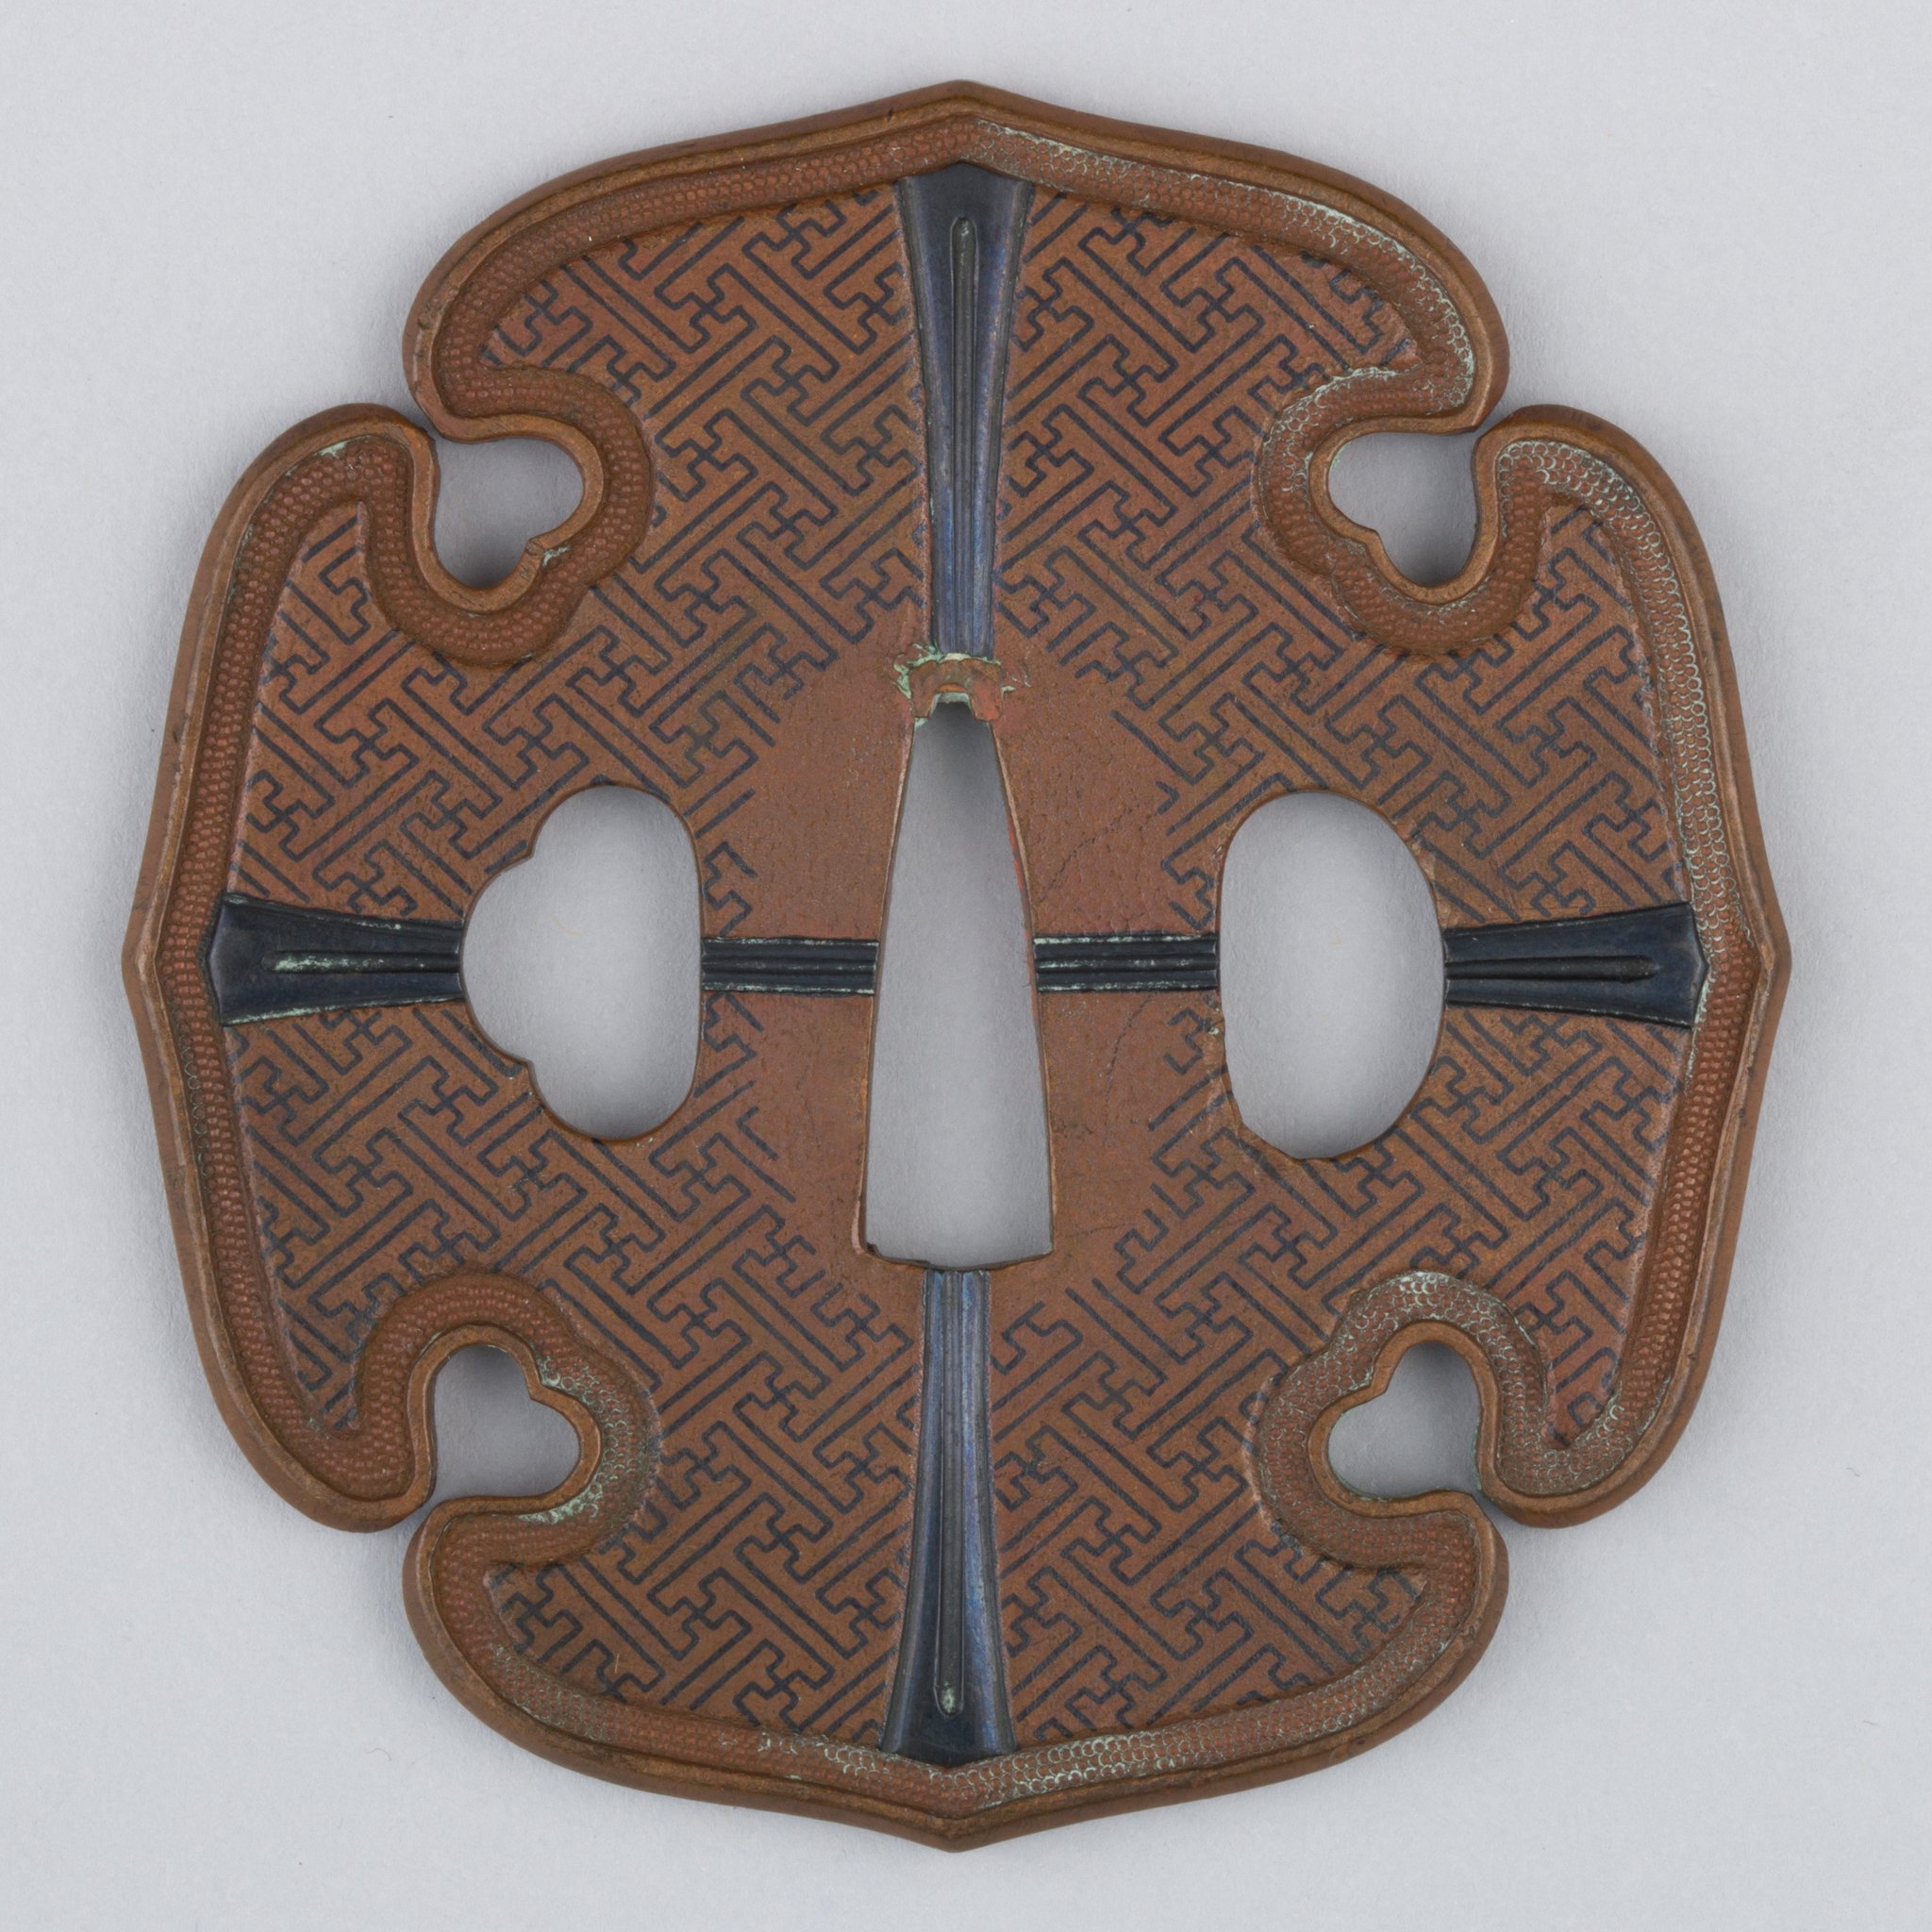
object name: sword guard tsuba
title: Sword Guard (Tsuba)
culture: japanese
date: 1701-1800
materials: copper, gold alloy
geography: japan